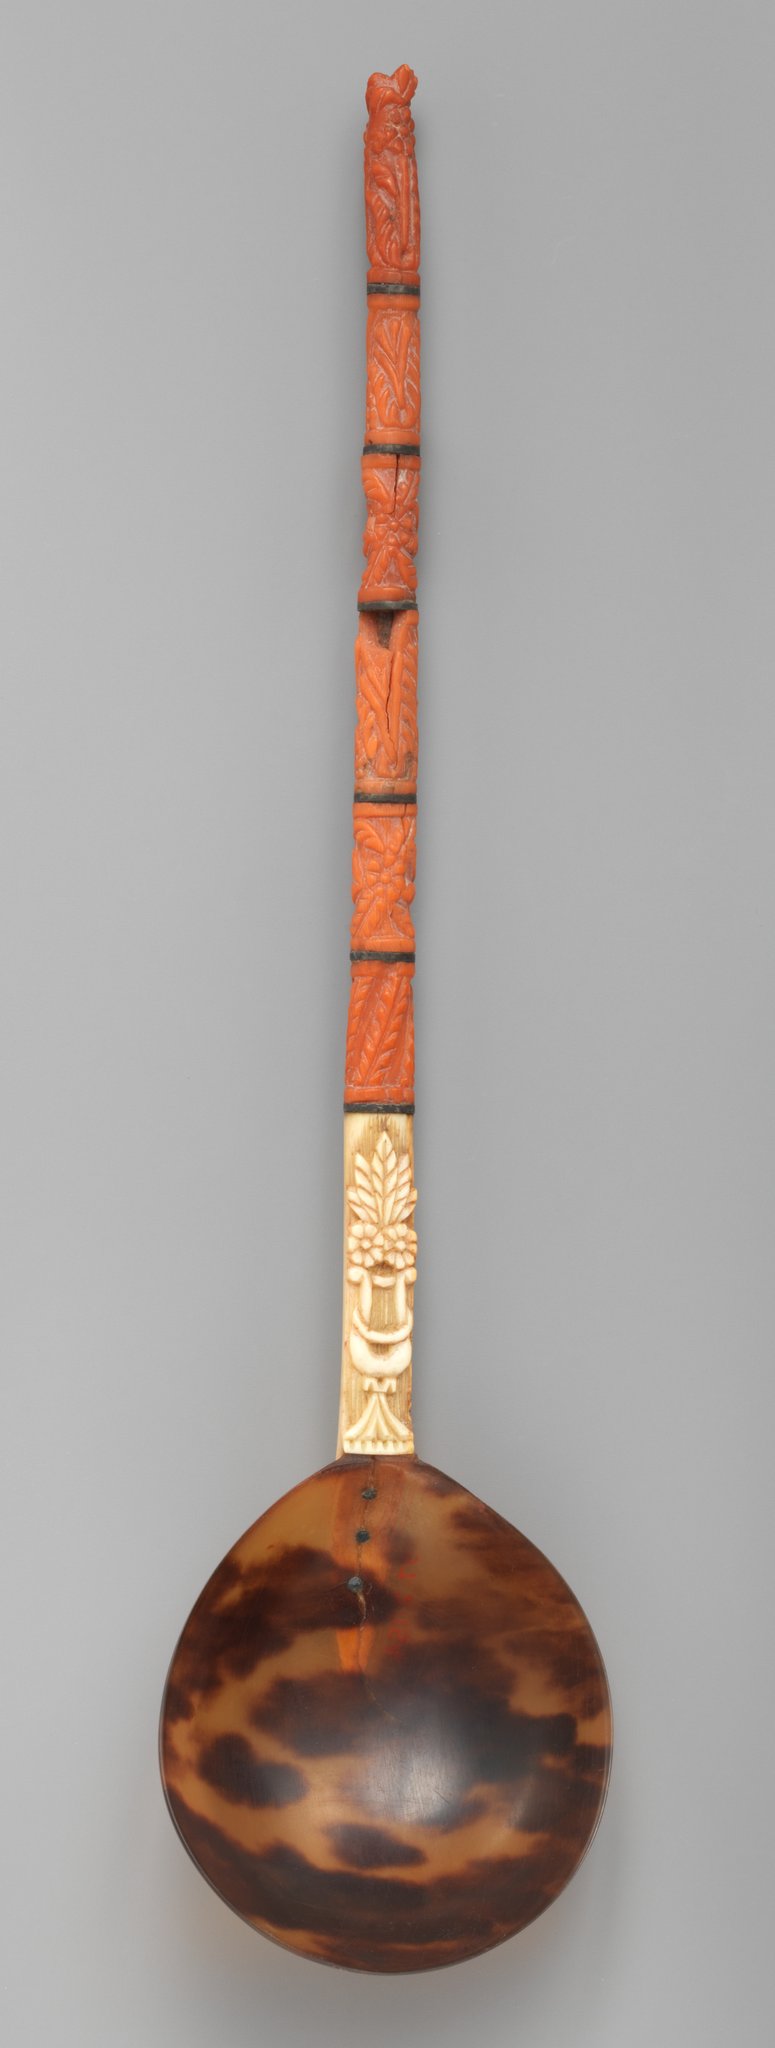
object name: spoon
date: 1701-1800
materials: brass, coral, ivory, shell